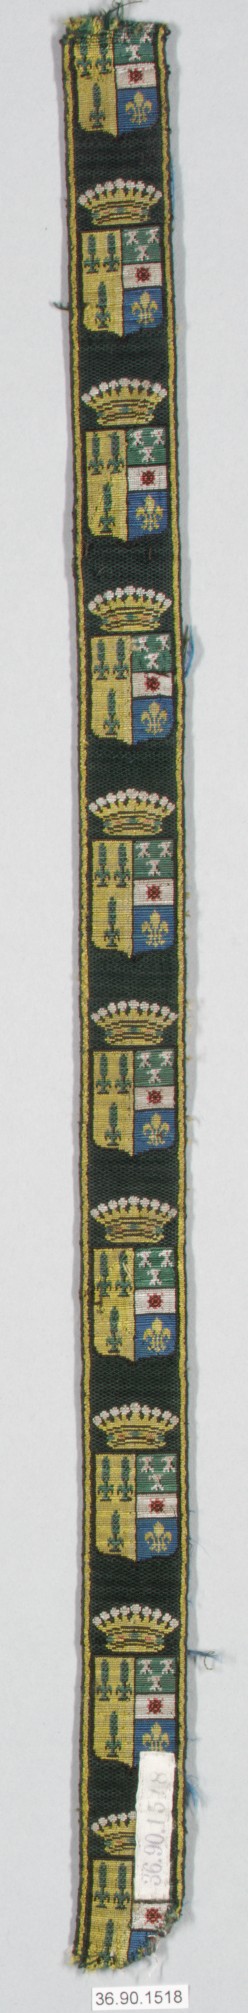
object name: galloon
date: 1701-1900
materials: silk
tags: coat of arms